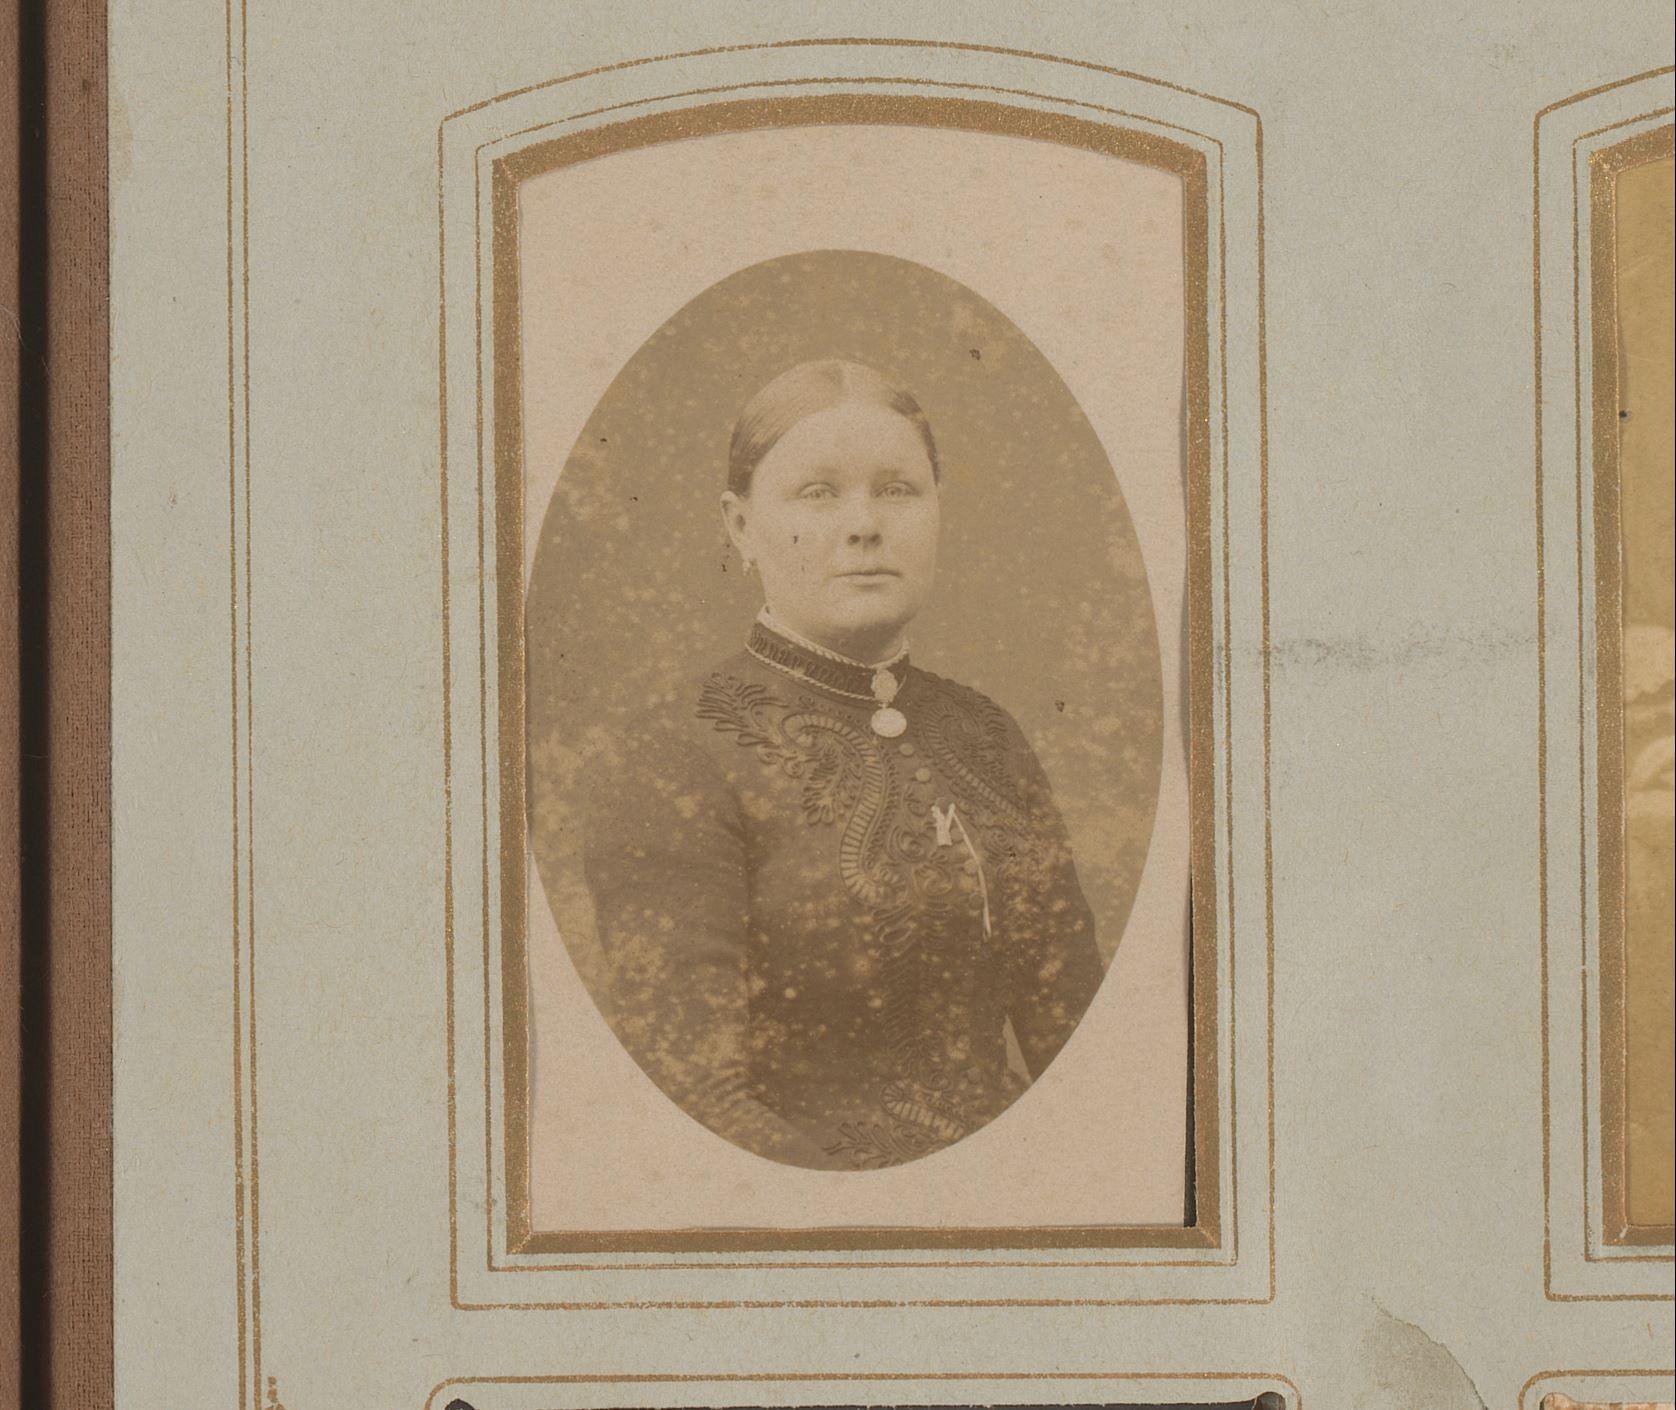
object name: photograph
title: Portret van een vrouw in geborduurde jurk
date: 1857-1898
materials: cardboard, photographic support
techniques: albumen print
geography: netherlands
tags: historical persons - bb - woman, dress, gown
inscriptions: inscription: ‘HILVERSUM./ Torenlaan./ P. Siewers & Zoon/ Photographen/ Edam./ Voorhaven./ Zondag en Maandag/ te/ HILVERSUM./ EDAM Dagelijks/ De plaat blijft voor nabestelling bewaard.’